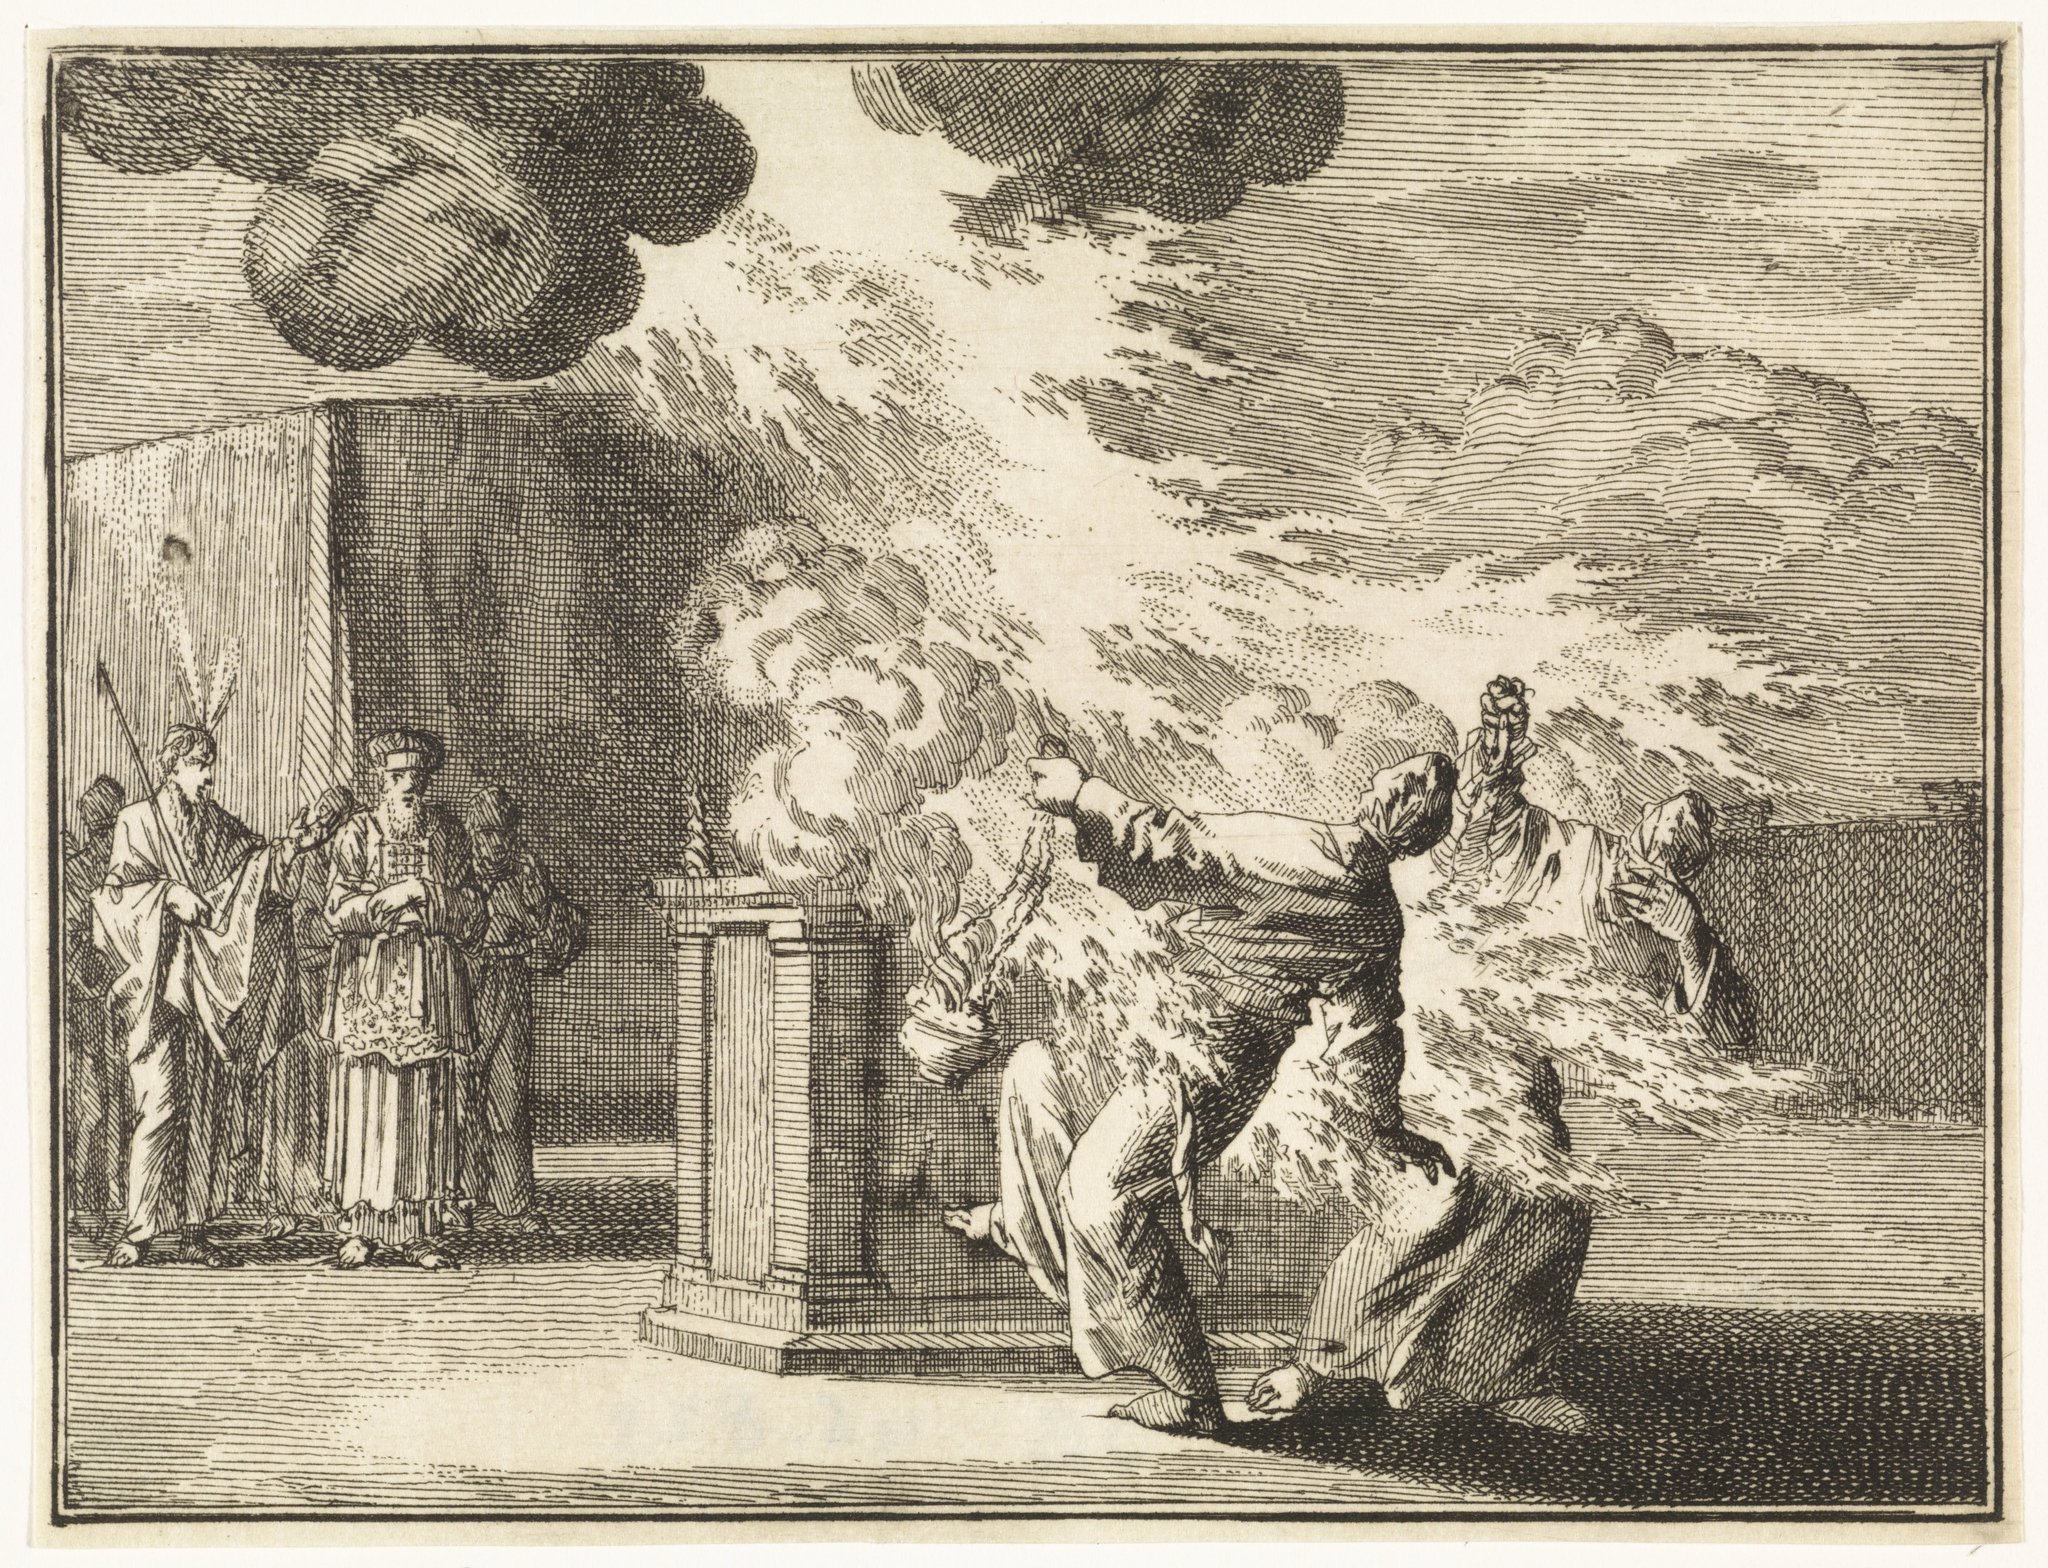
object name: print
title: Nadab en Abihu door vlammen gedood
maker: jan luyken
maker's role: draughtsman, print maker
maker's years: 1649-1712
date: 1712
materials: paper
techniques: etching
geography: amsterdam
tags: two sons of aaron, nadab and abihu, offer incense in their censers to god, who punishes them for this by sending a fire that kills them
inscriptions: collector's mark: Lugt 2228, number: ‘69’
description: Illustratie uit: Luyken, Jan. De schriftuurlyke geschiedenissen en gelykenissen van het Oude en Nieuwe Verbond, 2 delen. Amsterdam: Wed. Pieter Arentsz II en Cornelis van der Sys, 1712, dl. I.